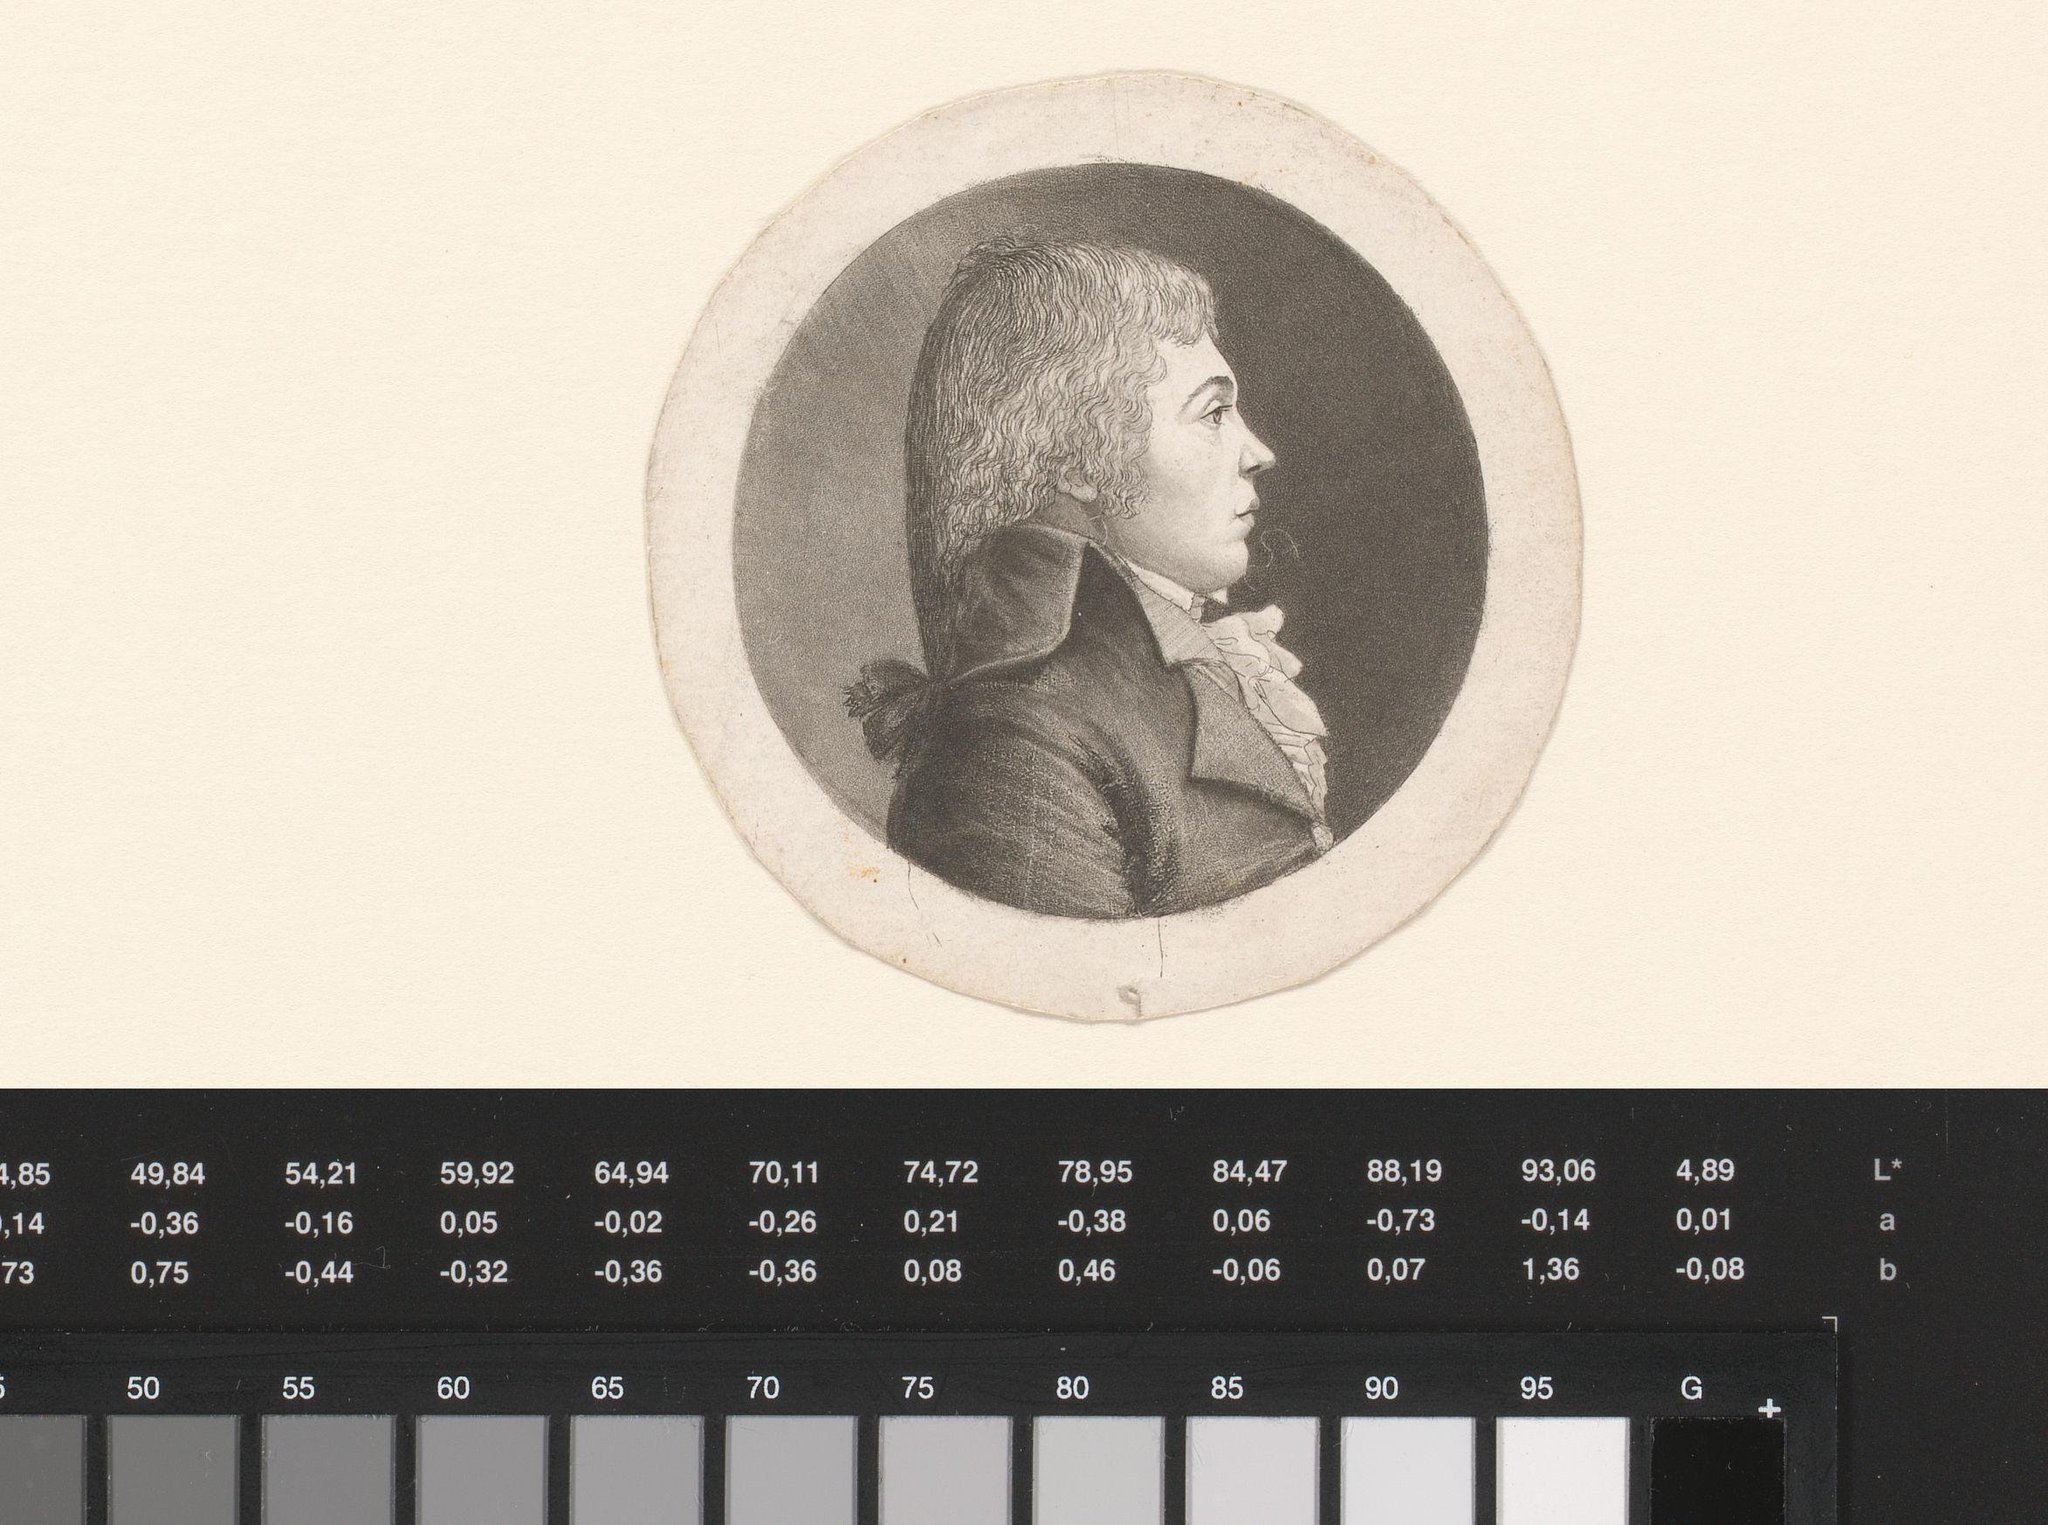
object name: print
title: Portret van een onbekende man met strik in haar, naar rechts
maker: Anonymous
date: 1770-1850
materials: paper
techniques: etching, roulette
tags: historical persons not known by name